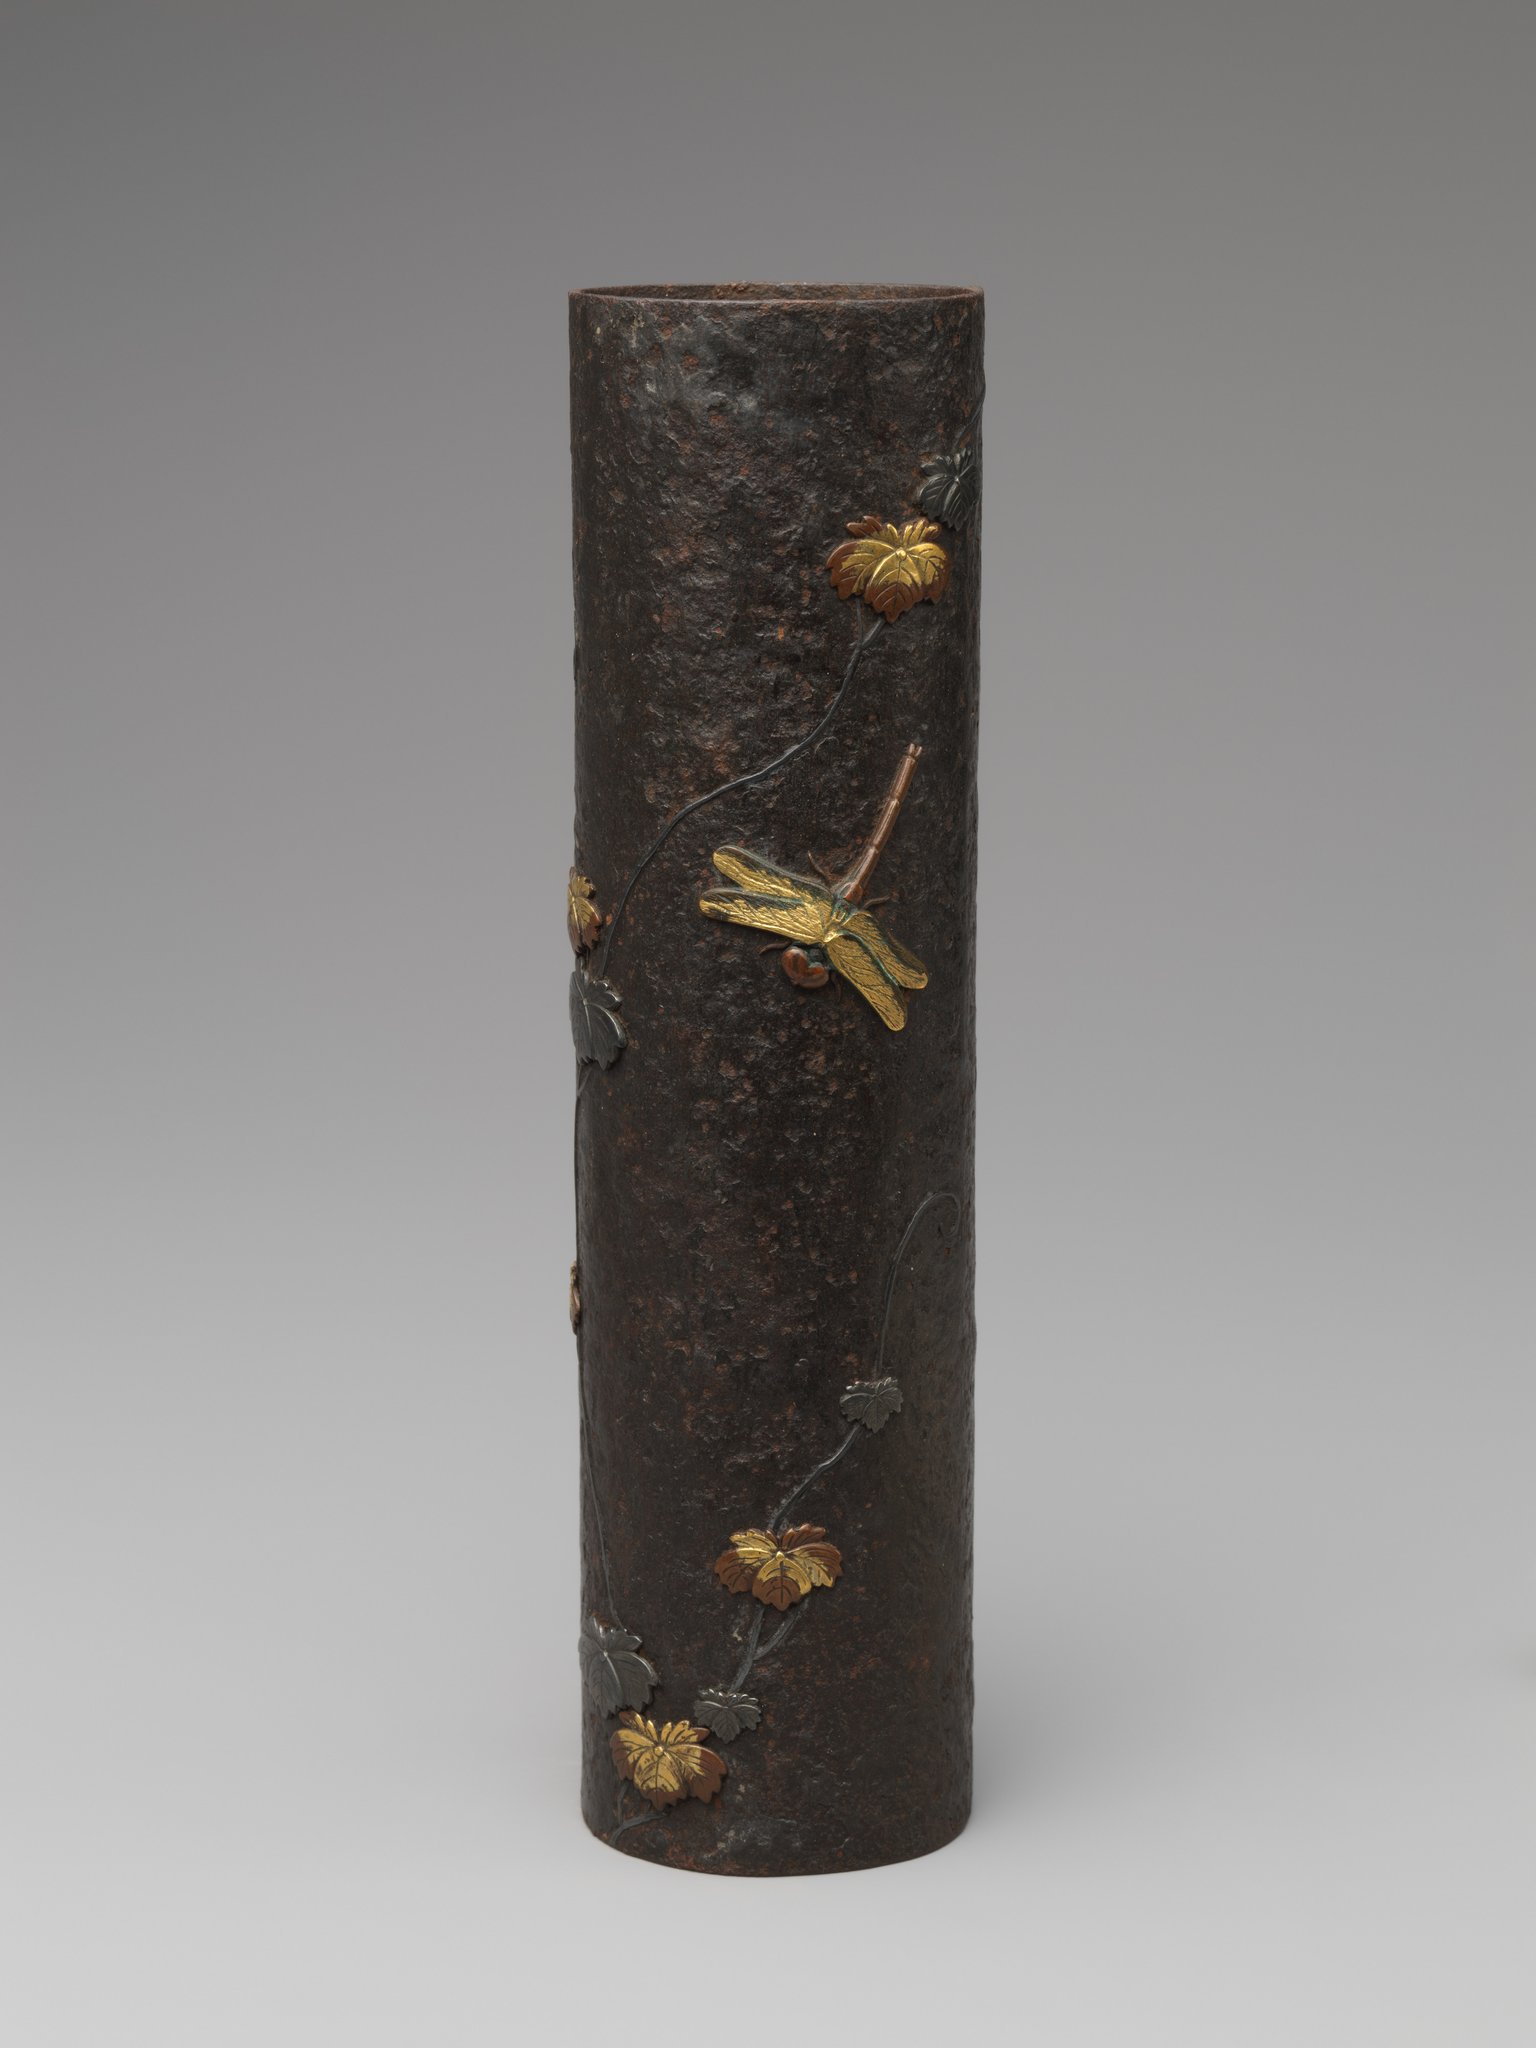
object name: hanging vase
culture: japanese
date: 1851-1900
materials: copper, iron, silver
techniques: gilding, inlay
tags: dragonflies,plants